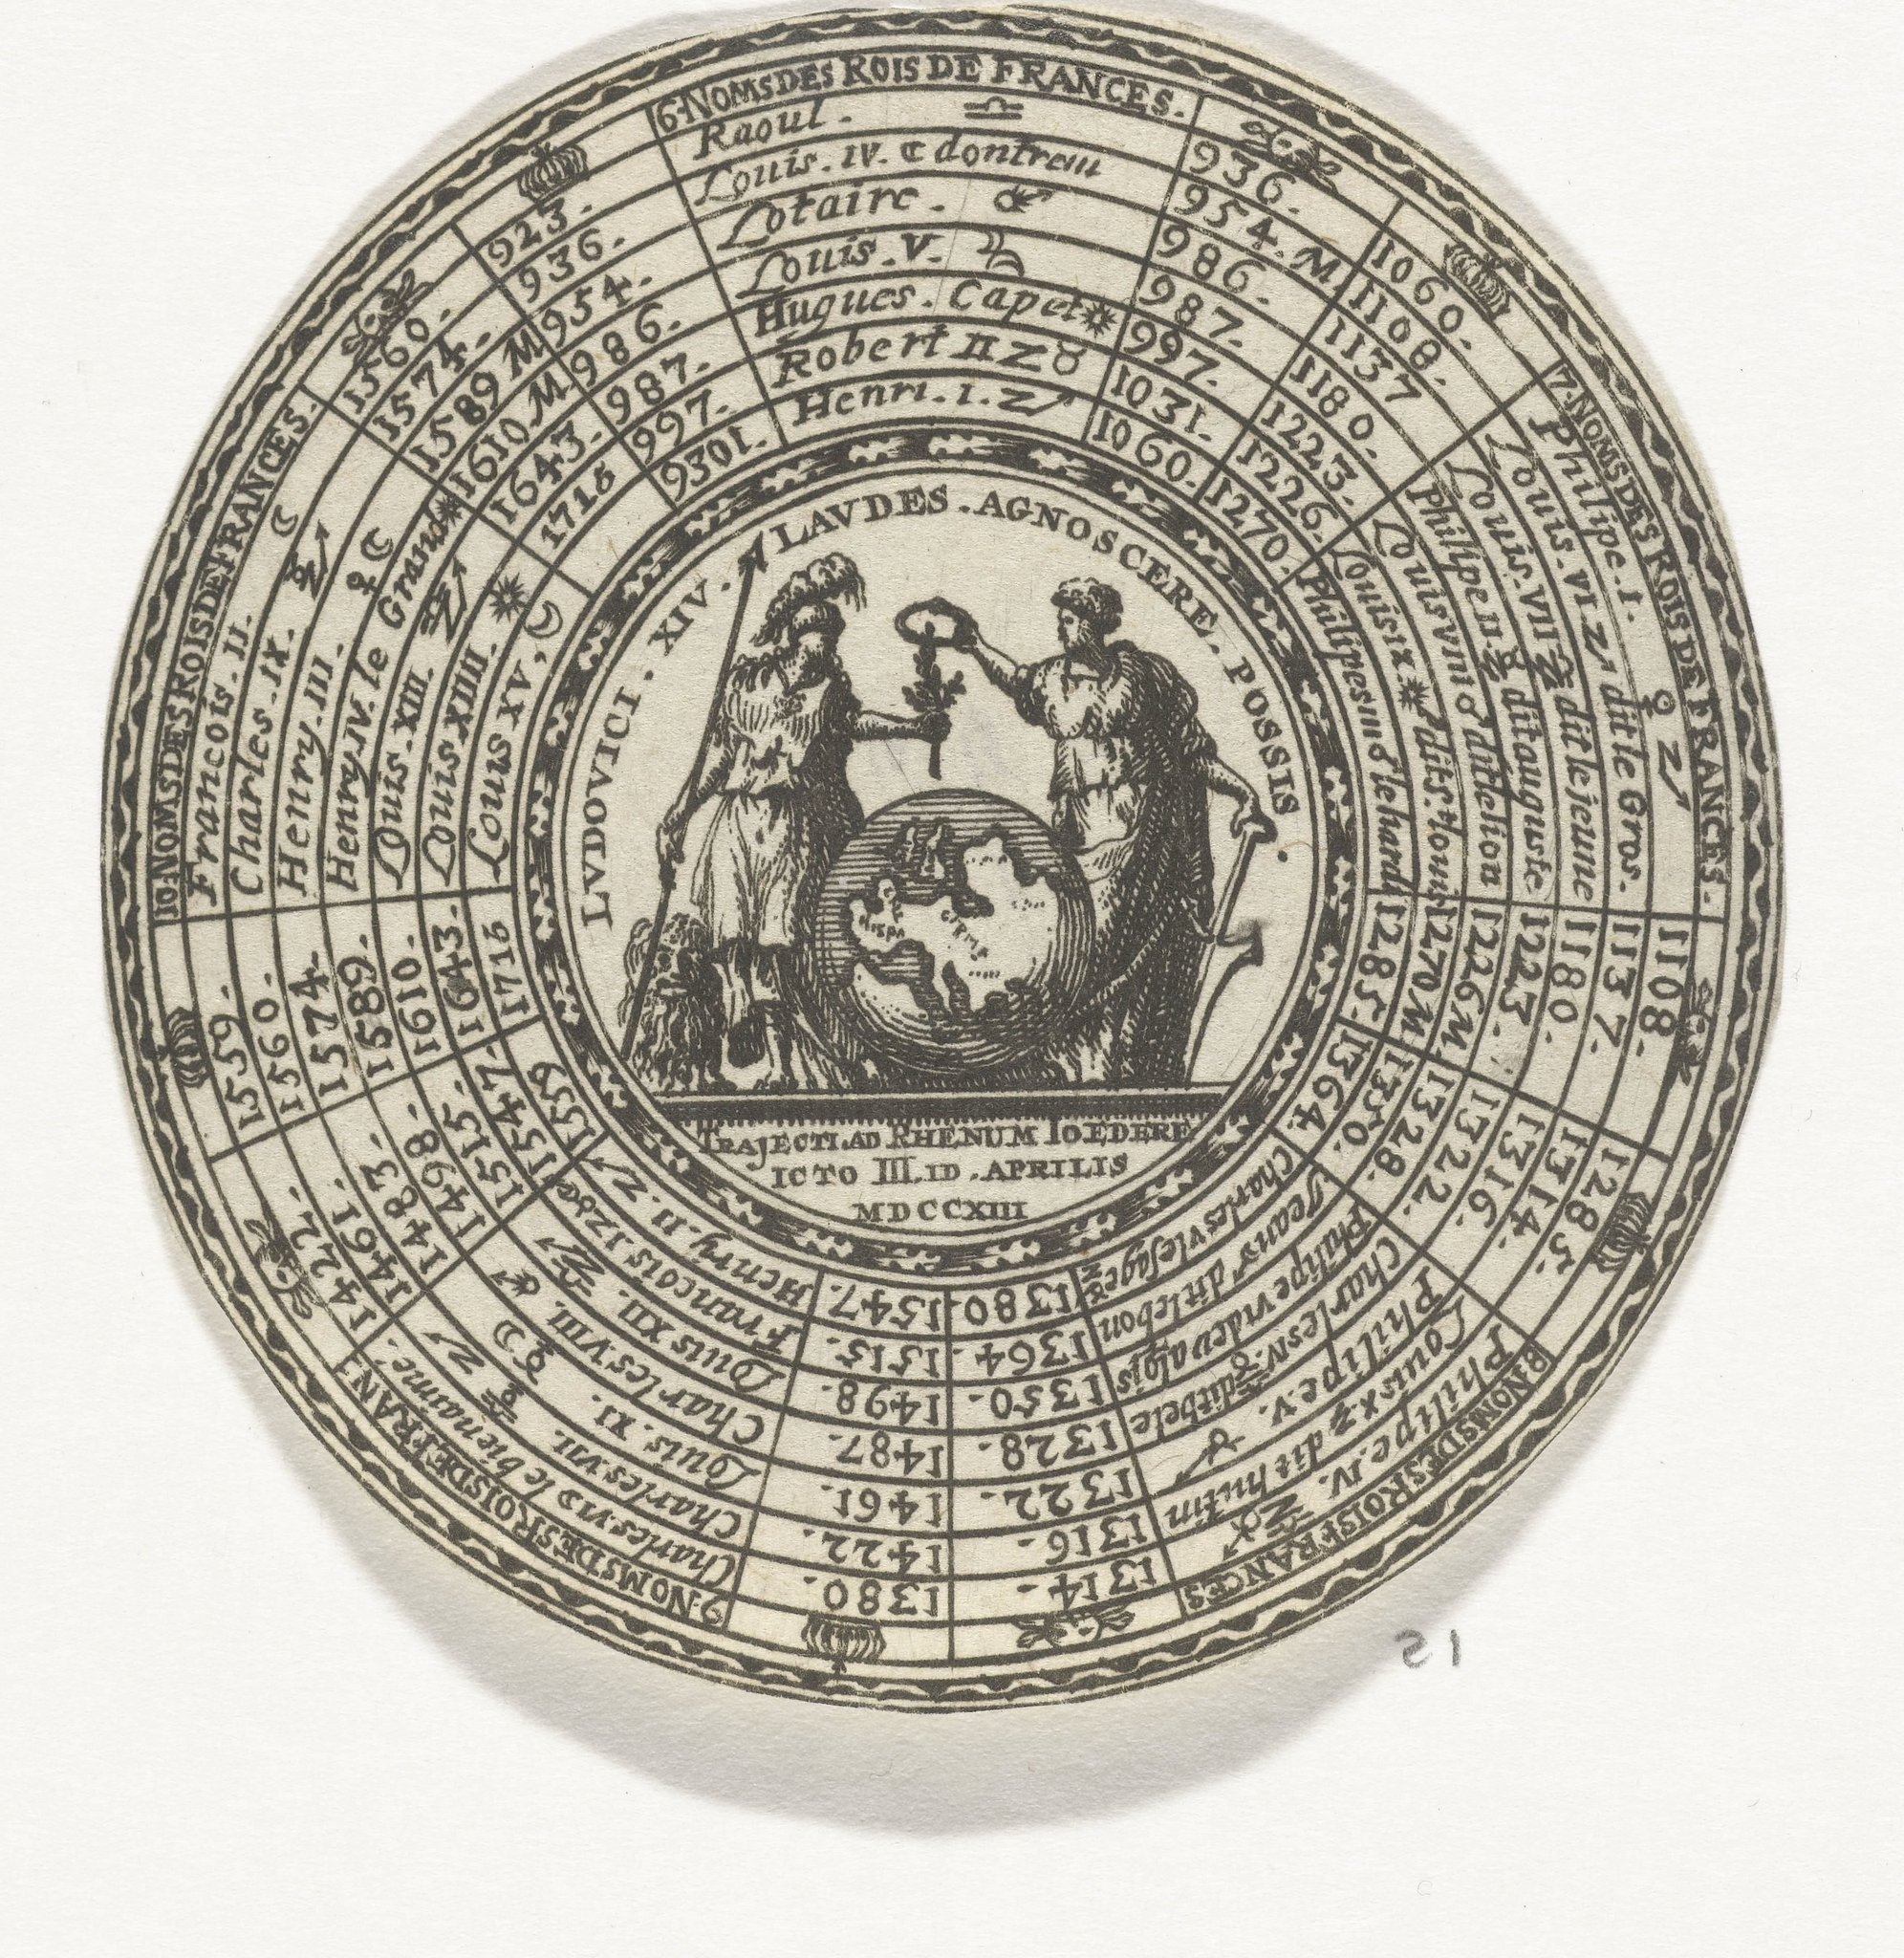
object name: print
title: Penning met een embleem en de namen van Franse koningen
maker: Anonymous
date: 1715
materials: paper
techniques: etching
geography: amsterdam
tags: (story of) ceres (demeter), (story of) minerva (pallas, athena), globe, abstract ideas and concepts (+ emblematical representation of concept), king, seal (symbol of sovereignty), crowning with laurel (+ wreath, garland ~ festive activities)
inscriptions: number: ‘22’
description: Ontwerp van een ronde penning met, in acht concentrische cirkels, de namen van Franse koningen en hun regeringsjaren, beginnende bij koning Rudolf I en eindigend bij koning Lodewijk XV. In het midden van de penning een embleem met Ceres en Minerva, die de wereldbol met een lauwerkrans kronen. Het motto leest: "Laudes agnoscere possis".